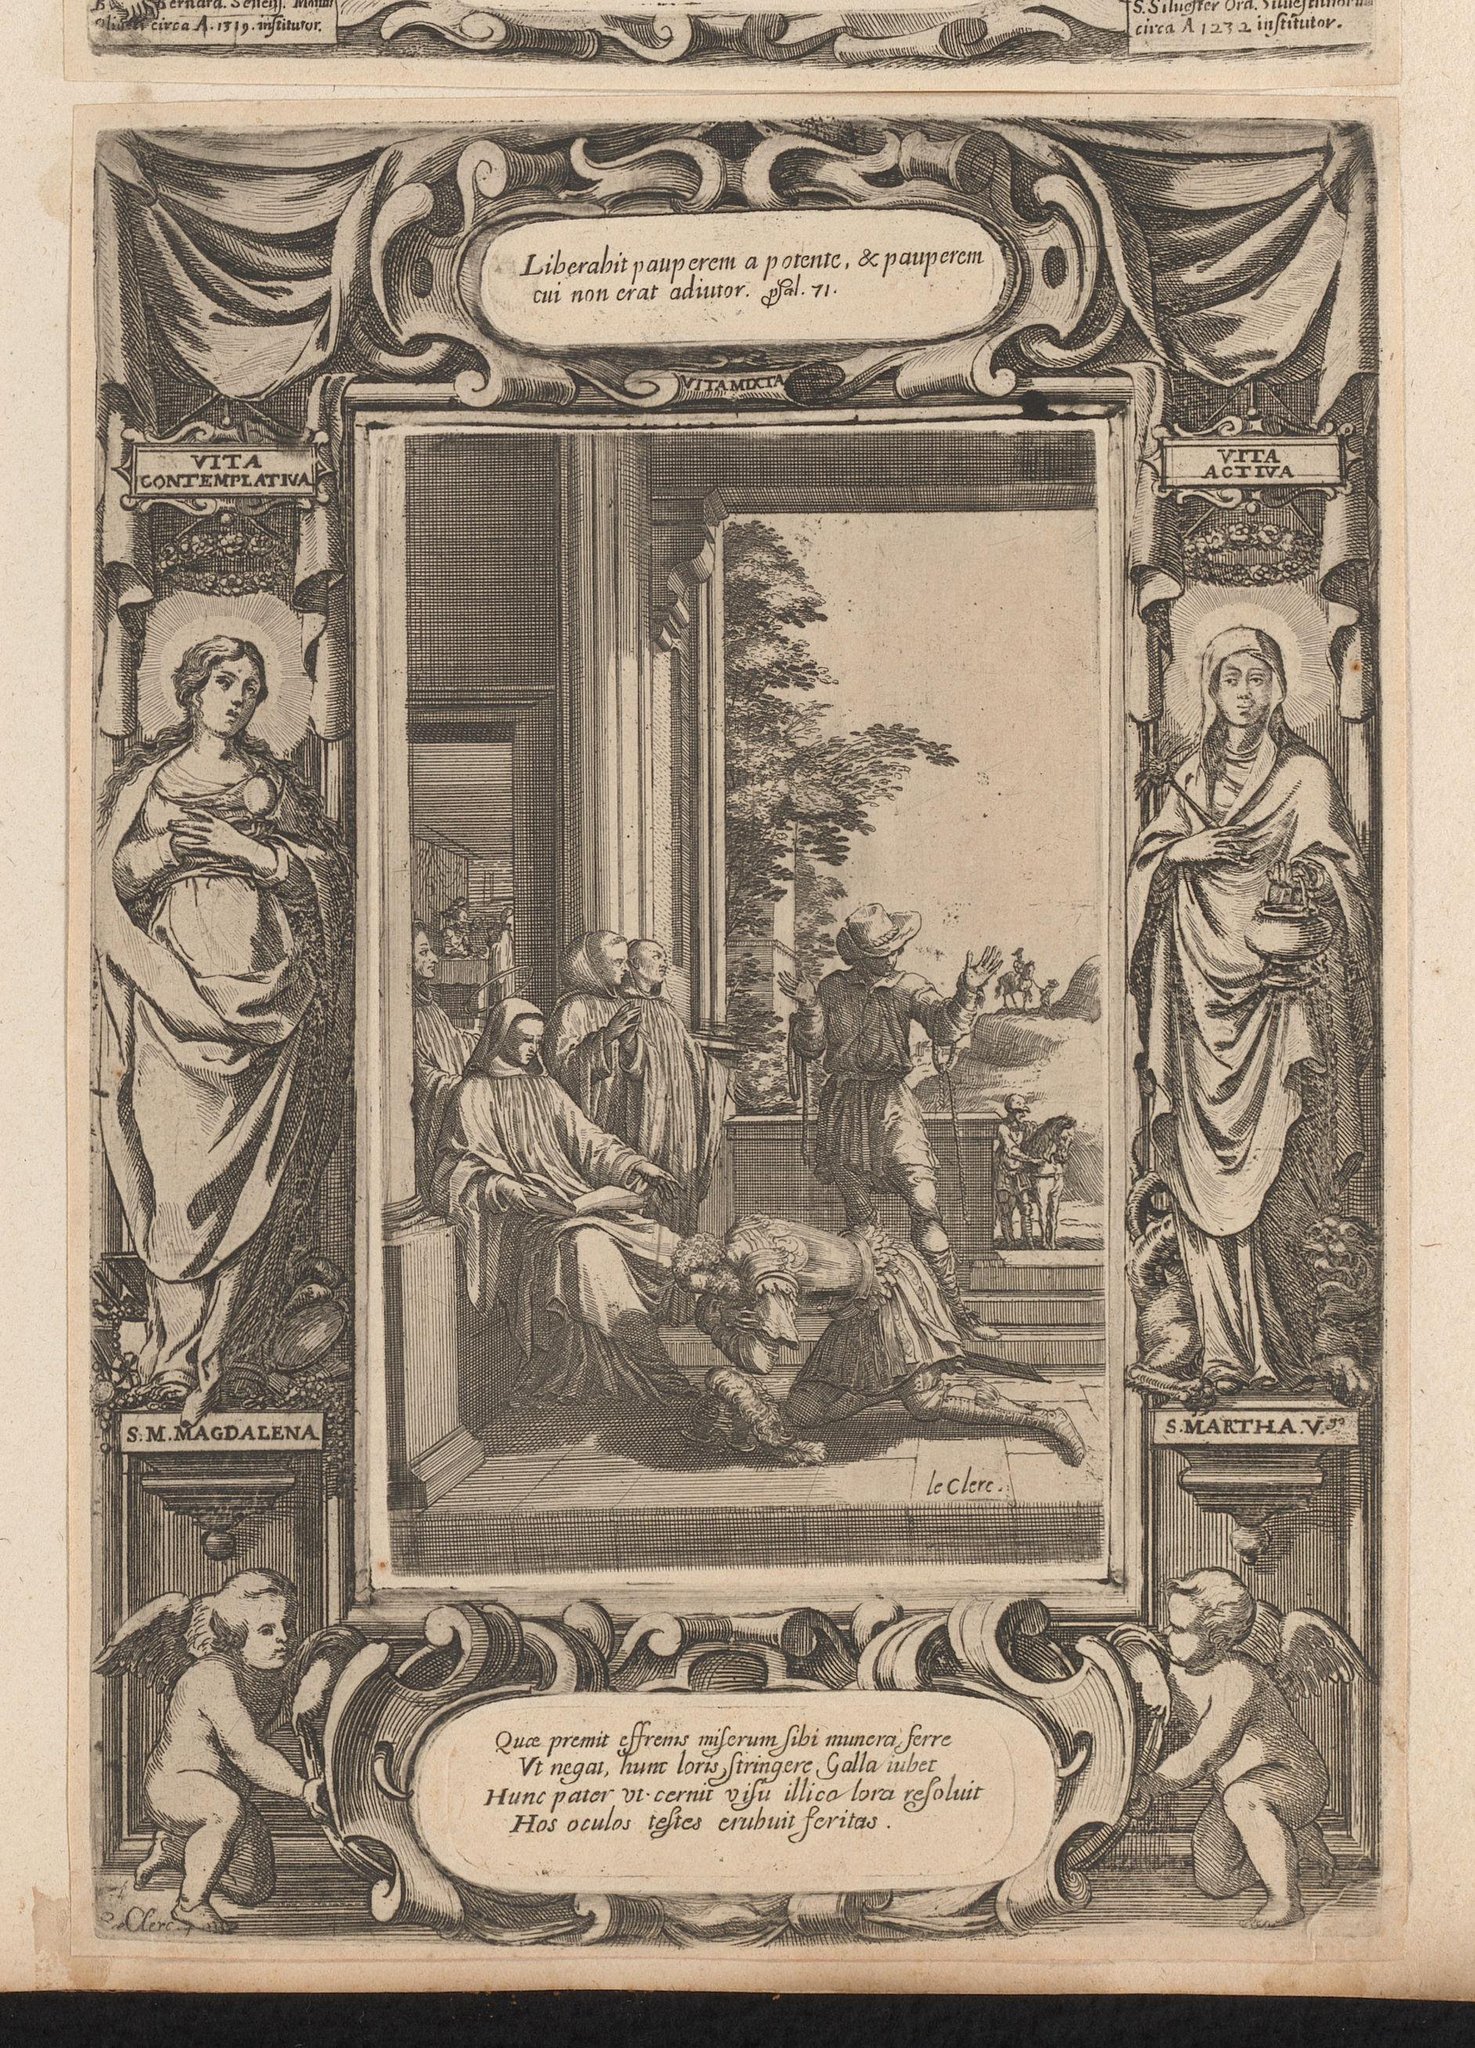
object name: album leaf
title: Galla knielt voor de H. Benedictus, in een cartouche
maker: sébastien leclerc (i)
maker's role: print maker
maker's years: 1637-1714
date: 1658-1659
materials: paper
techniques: etching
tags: benedict of nurcia, abbot of monte cassino and founder of the benedictine order; possible attributes: aspergillum, book, cup (sometimes broken), raven with loaf, sieve (or tray), monastic orders, monastic life: benedictines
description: Maakt deel uit van een serie bestaande uit 33 prenten met voorstellingen uit het leven van de Heilige Benedictus van Nursia in ornamentele cartouches, uitgegeven in 1658-1659. De prenten zijn gedrukt van drie afzonderlijke platen bestaande uit de voorstelling, de cartouche en de tekst.